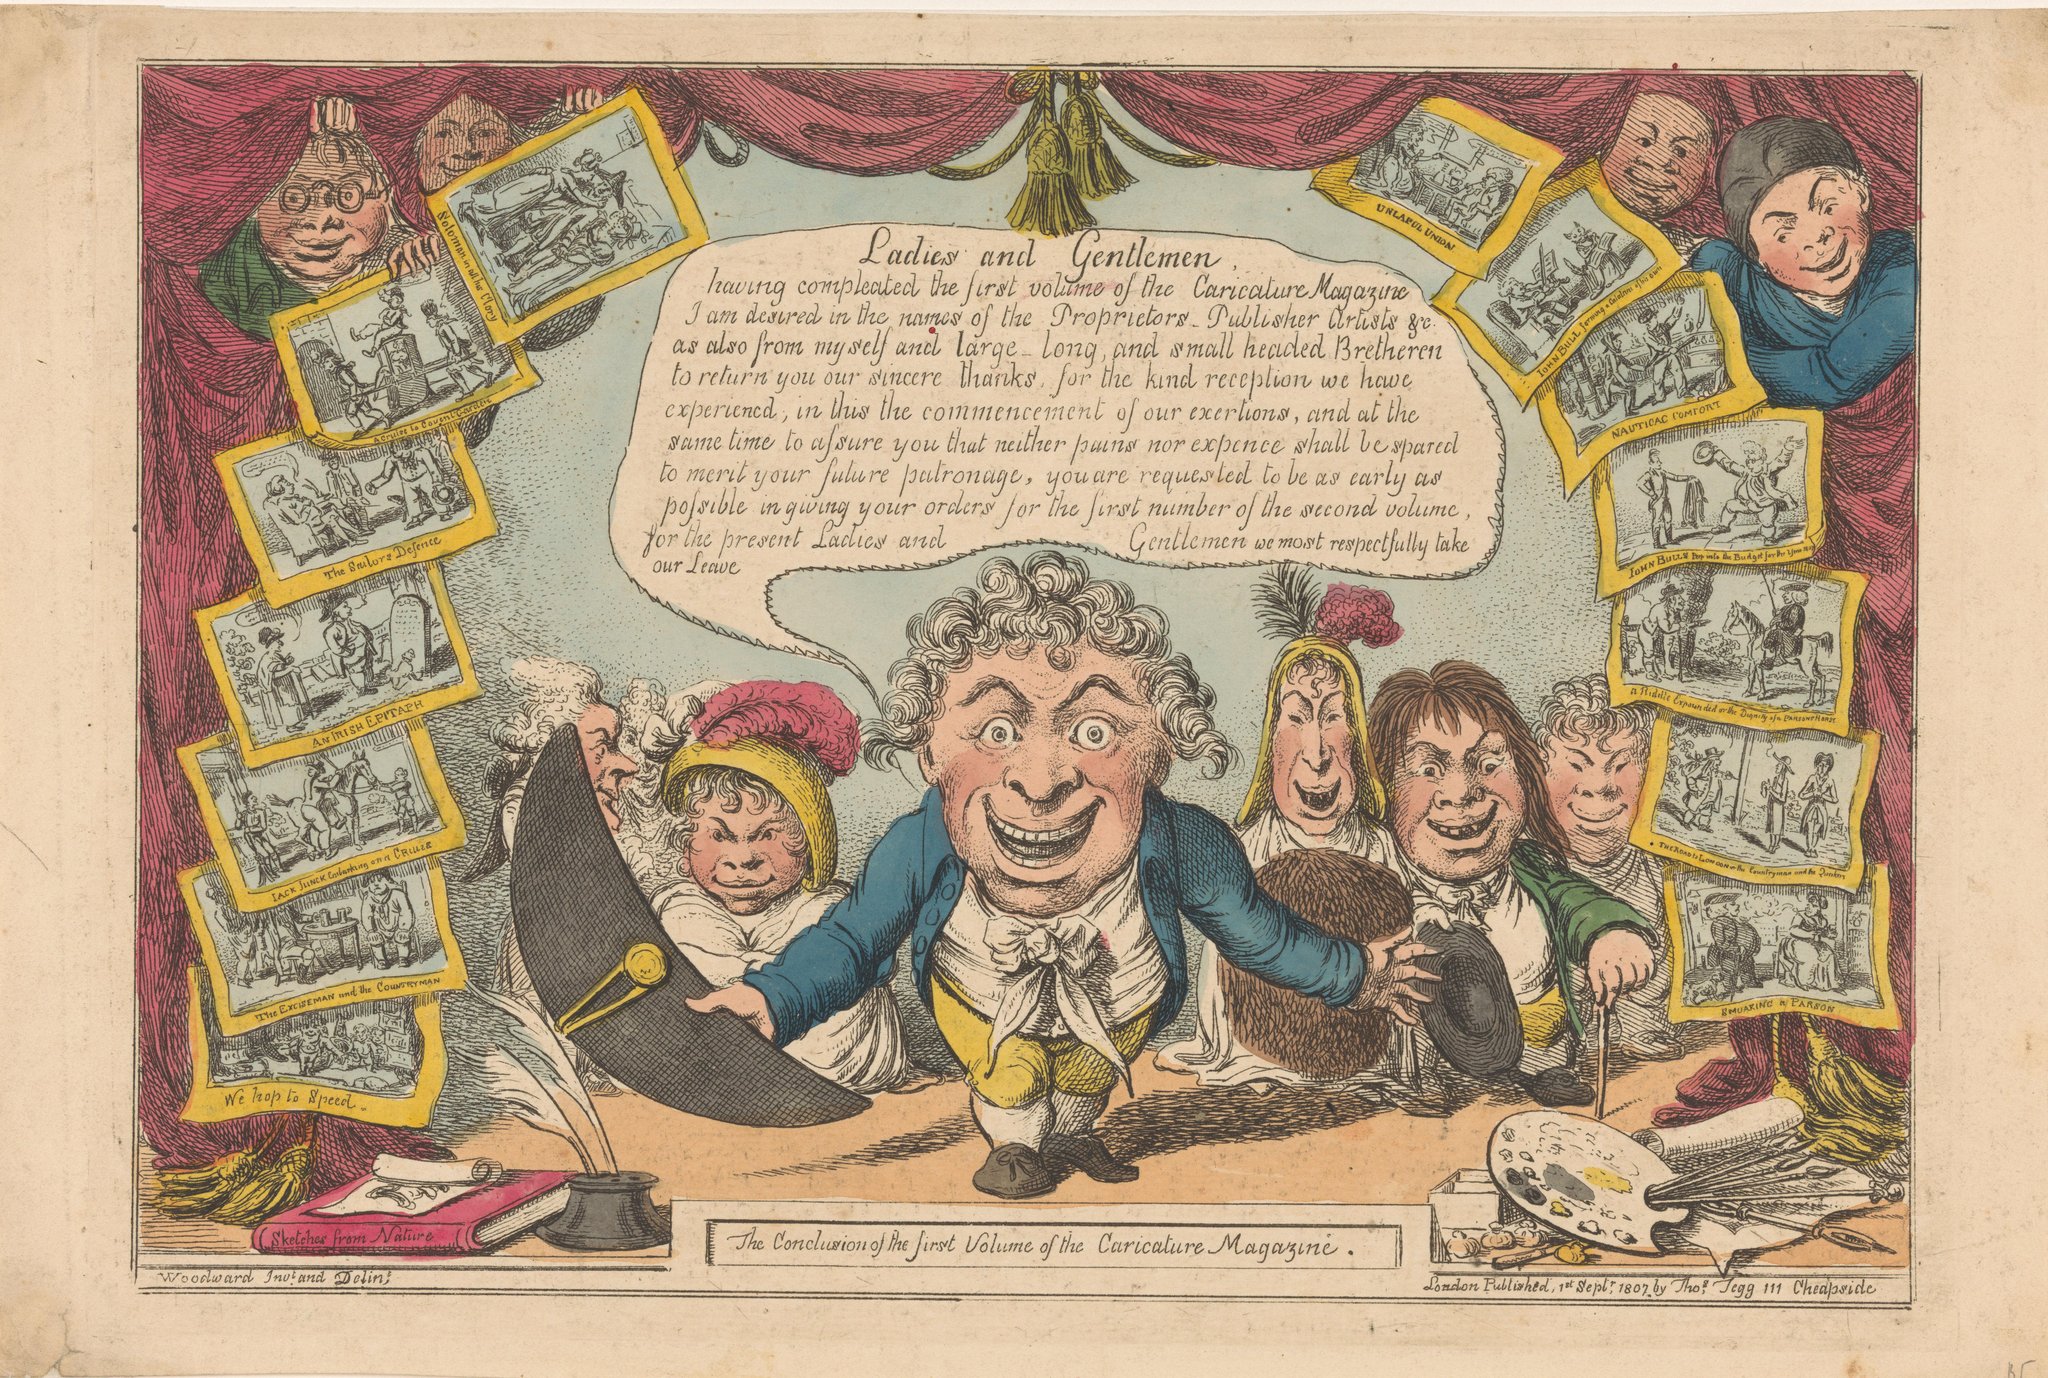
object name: illustration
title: Karikaturale figuren op een toneel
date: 1807-1809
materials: paper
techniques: etching, hand coloring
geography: london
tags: curtain ~ stage, caricatures (human types), ink-well, print, e.g.: engraving, etching, lithograph, tools, implements of painter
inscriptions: collector's mark: Lugt 2228, collector's mark: Lugt 4779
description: Karikaturale figuren op een toneel, de middelste man neemt zijn hoed af en spreekt de tekst die wordt weergegeven in een tekstballon. Rondom een rood gordijn waarop de veertien prenten te zien zijn die de betreffende aflevering van The Caricature Magazine voorkomen. Op de voorgrond links een boek en een inktpot met schrijfveer en rechts schildersattributen en een etsnaald.